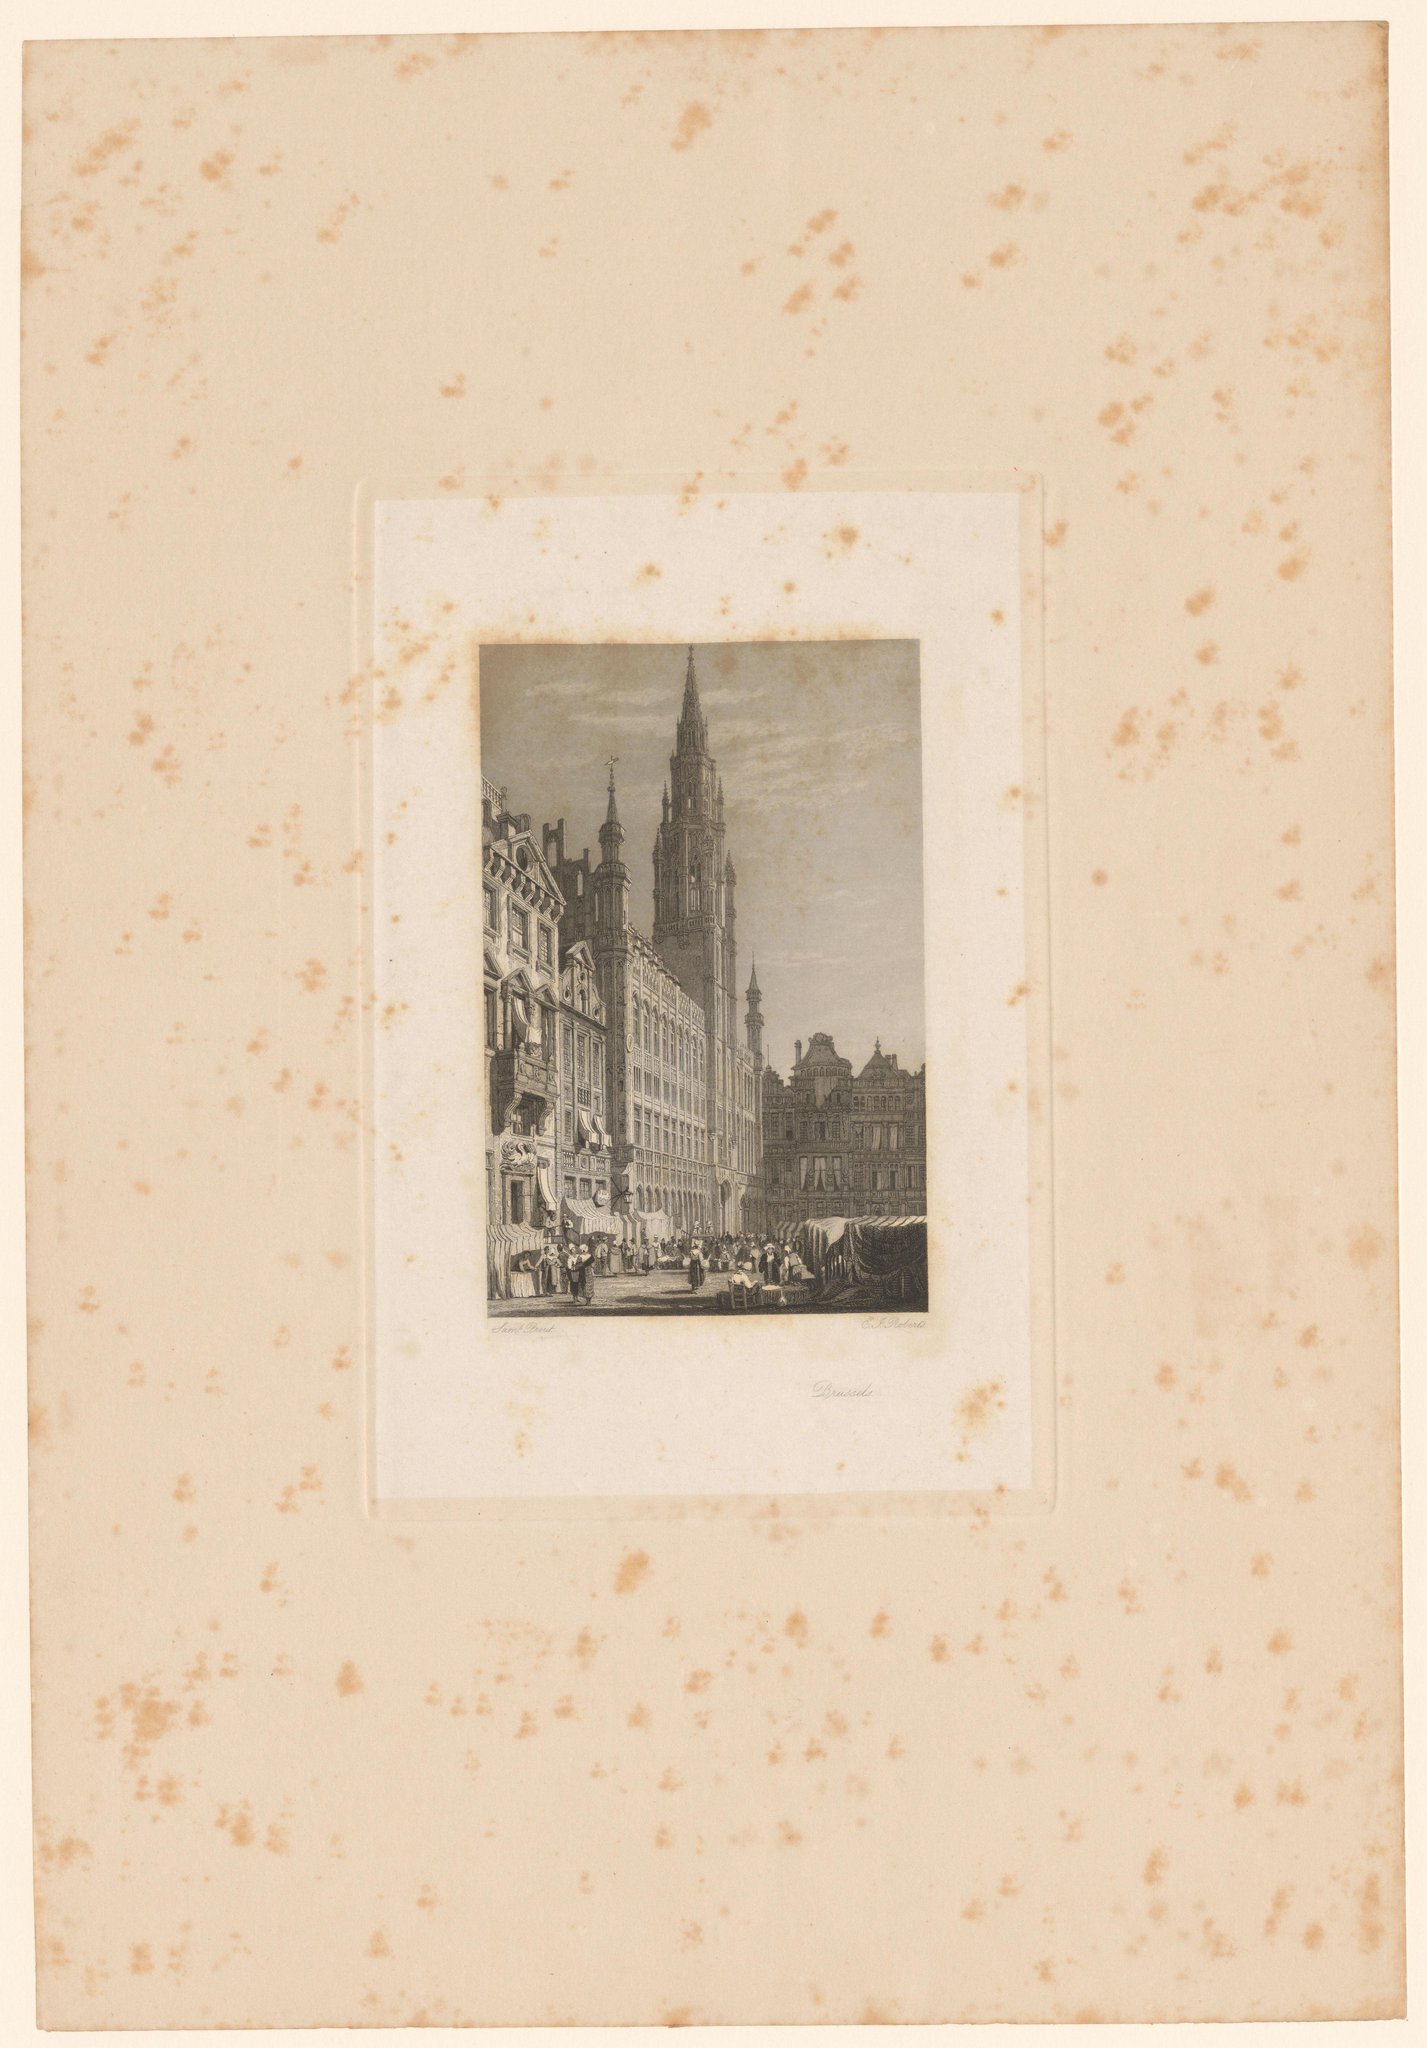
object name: print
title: Brussels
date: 1806-1865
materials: paper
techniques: etching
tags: townhall, public road (+ city(-scape) with figures, staffage), brussels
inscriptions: collector's mark: Lugt 2228